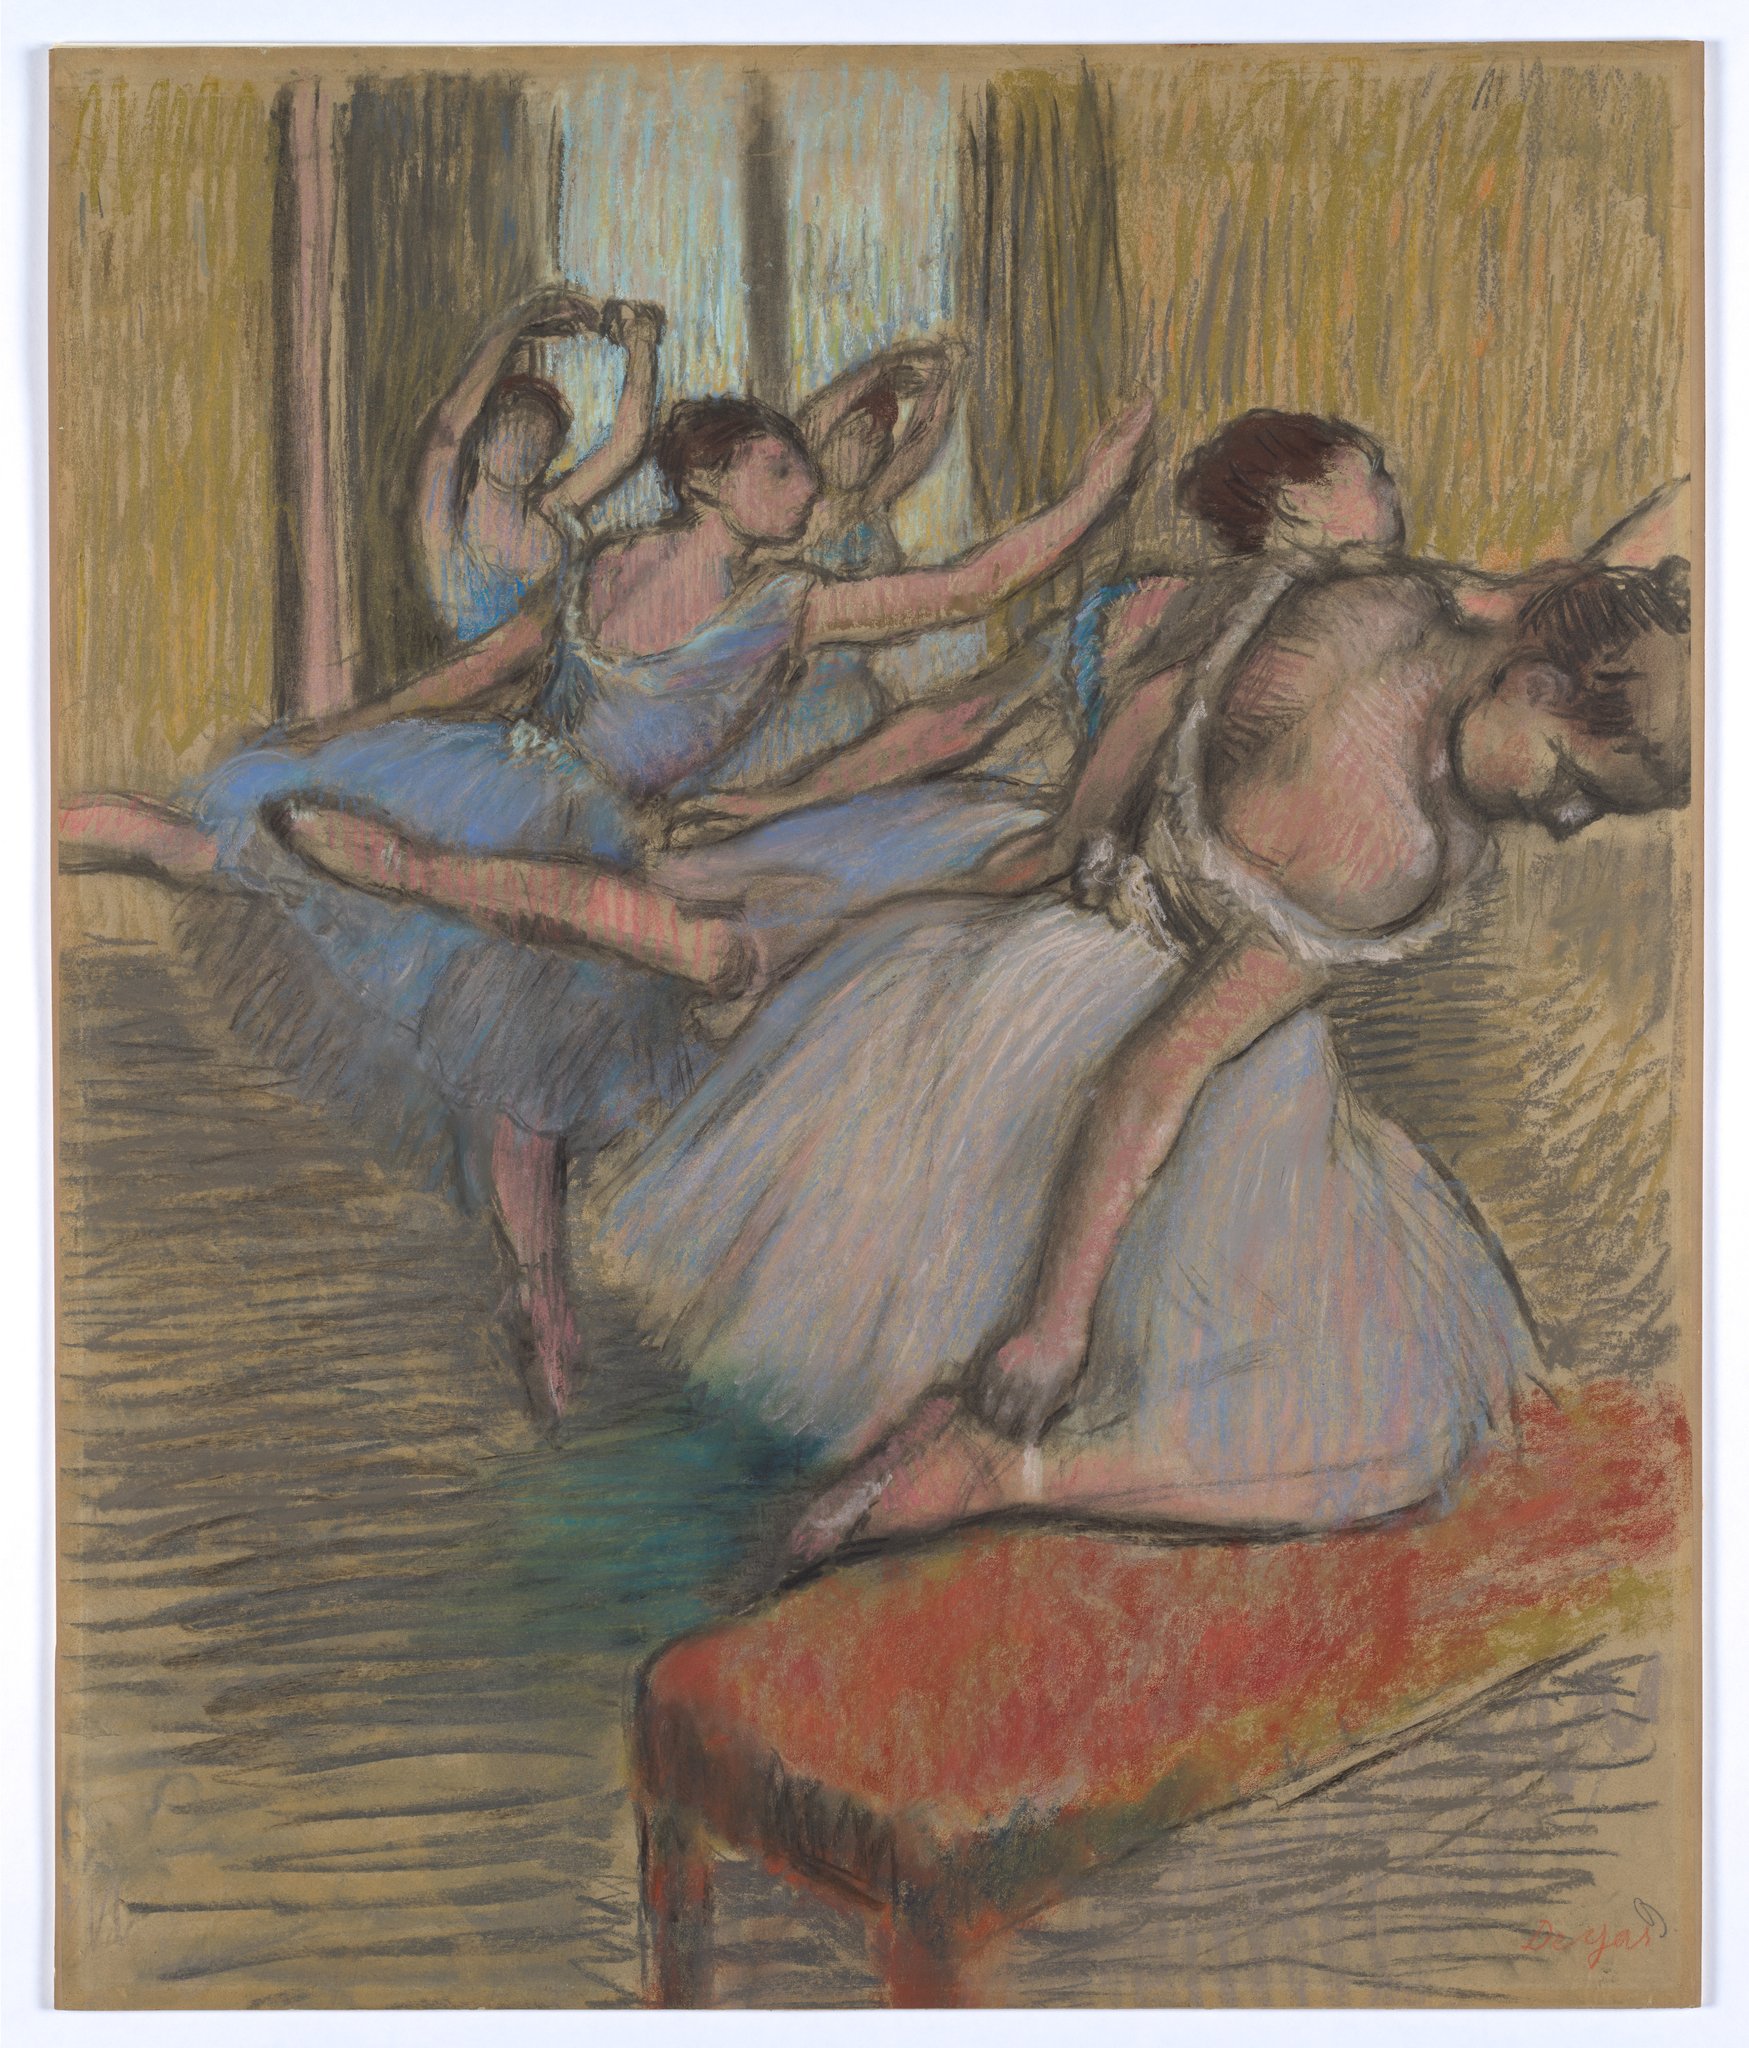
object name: drawing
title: The Dancers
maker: edgar degas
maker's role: artist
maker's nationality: french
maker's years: 1834-1917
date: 1854-1917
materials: charcoal, paper, pastel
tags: women,dancers,ballet